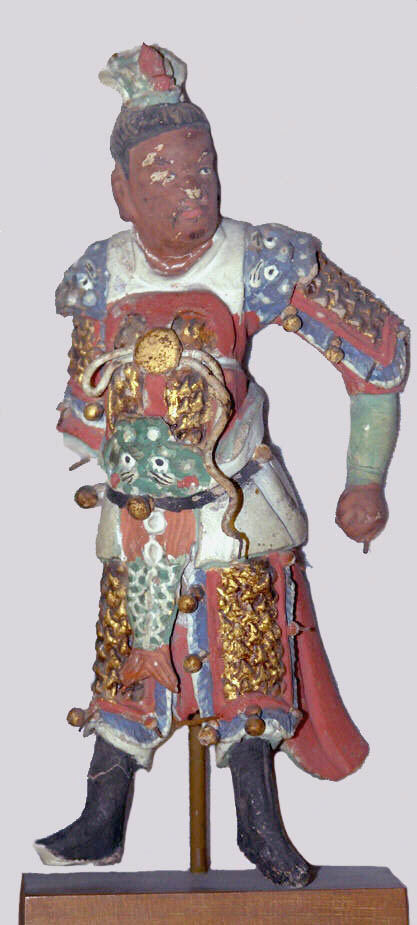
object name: statuette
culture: chinese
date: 1601-1700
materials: mud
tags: men